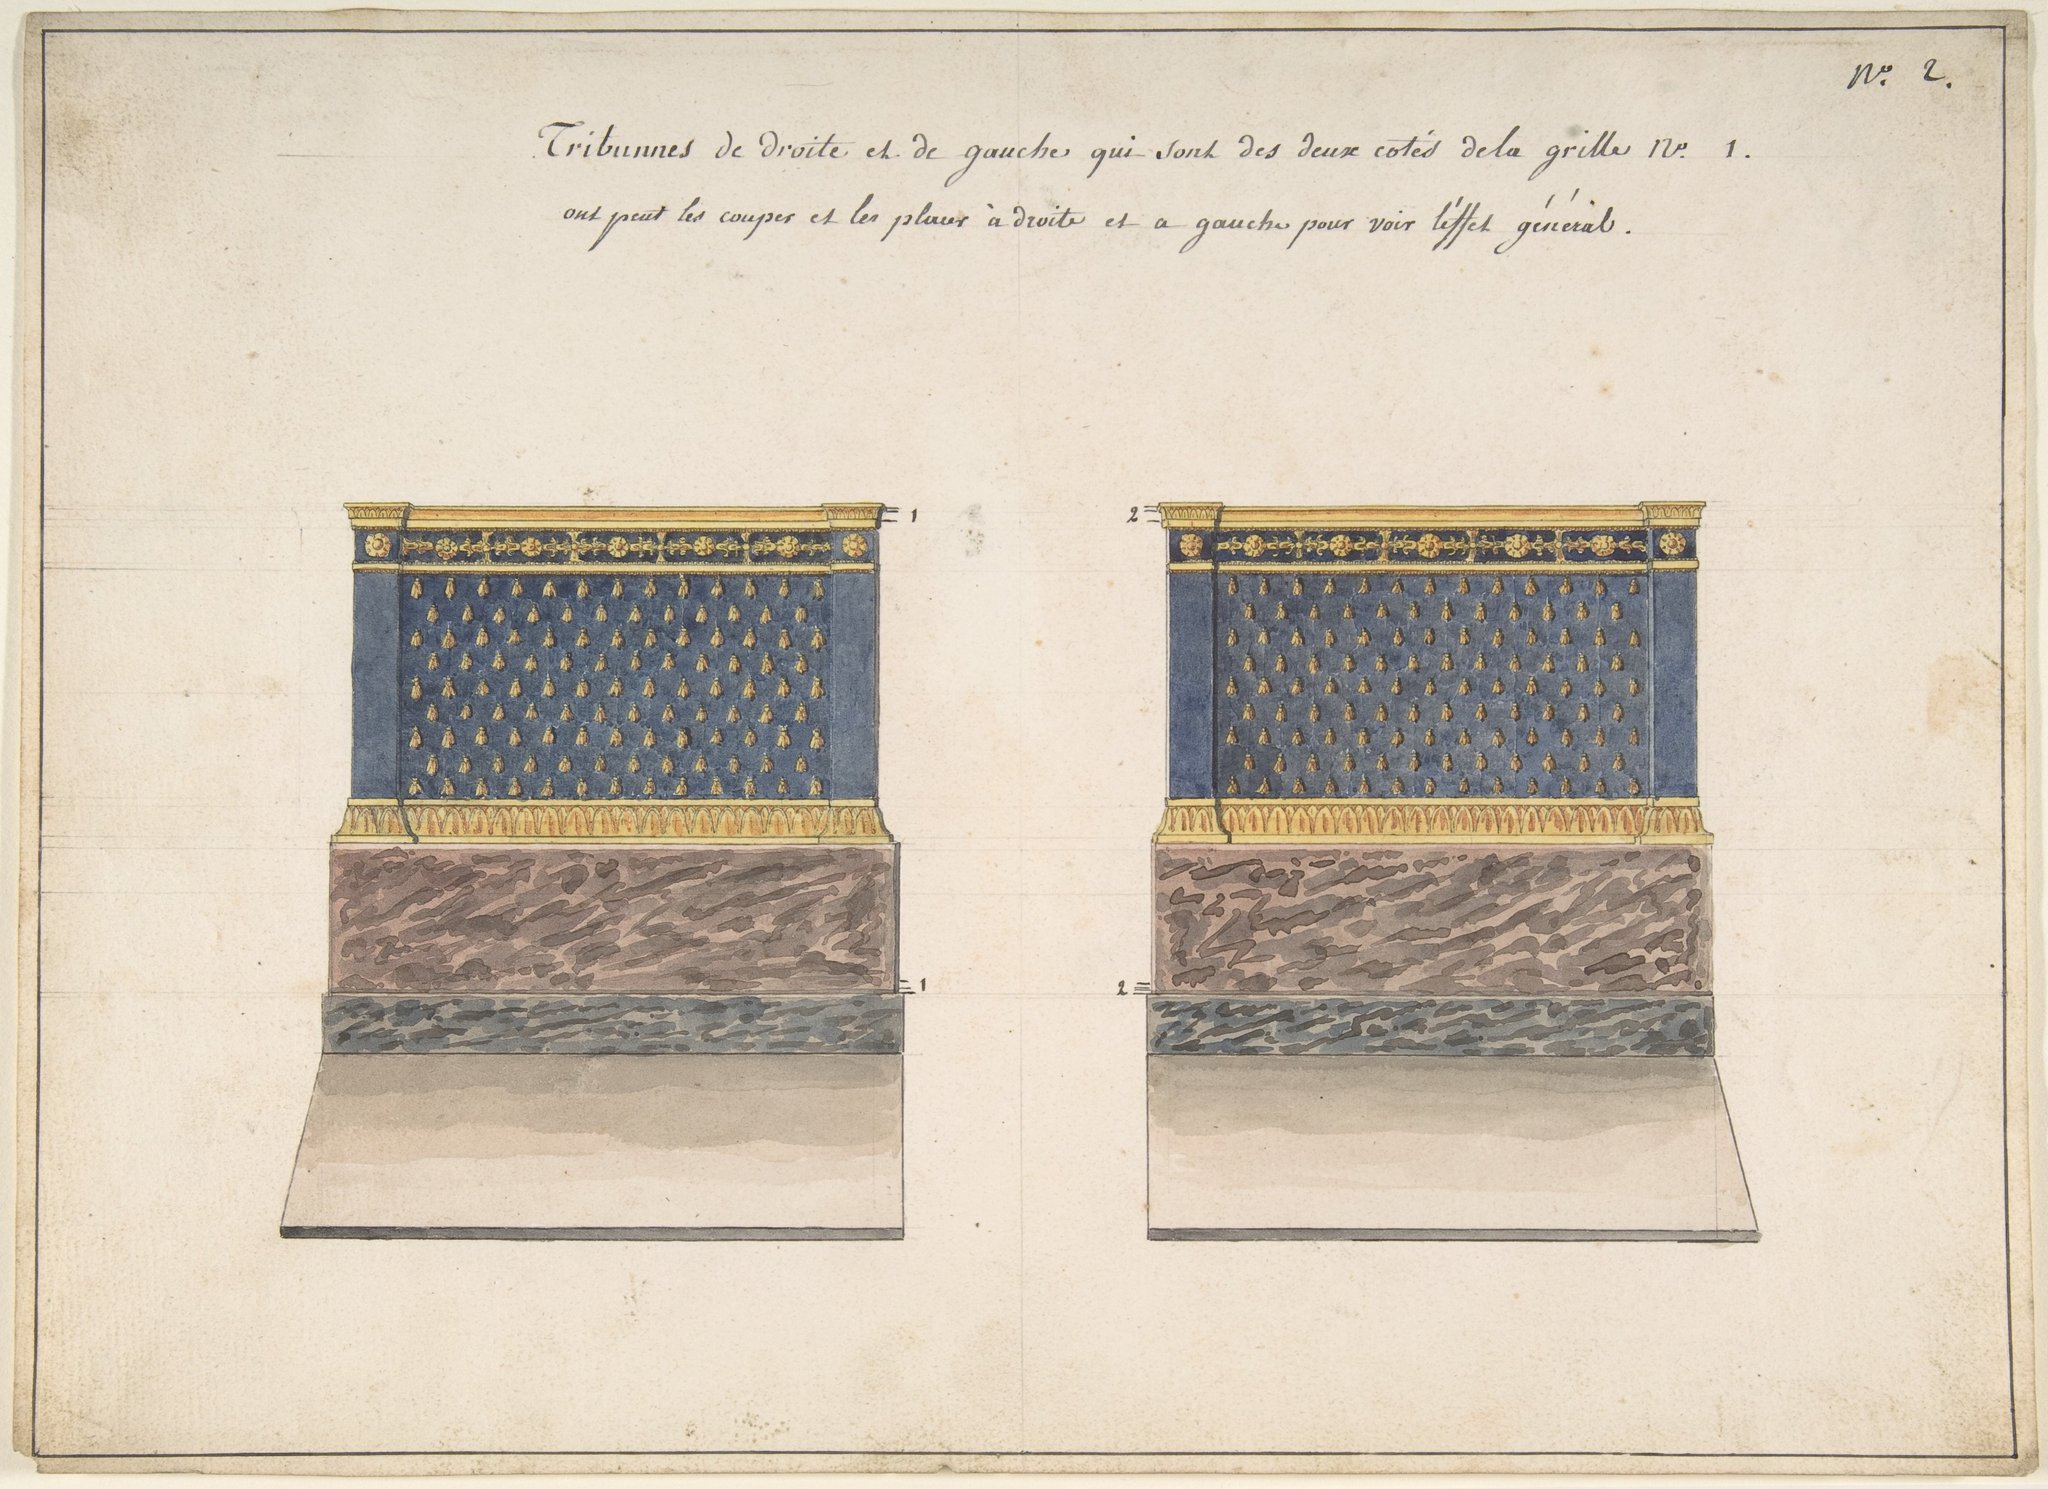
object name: drawing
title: Right and Left Tribunes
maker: charles percier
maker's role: designer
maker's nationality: french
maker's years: 1764-1838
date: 1764-1838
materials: graphite, ink, watercolor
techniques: pen, drawing